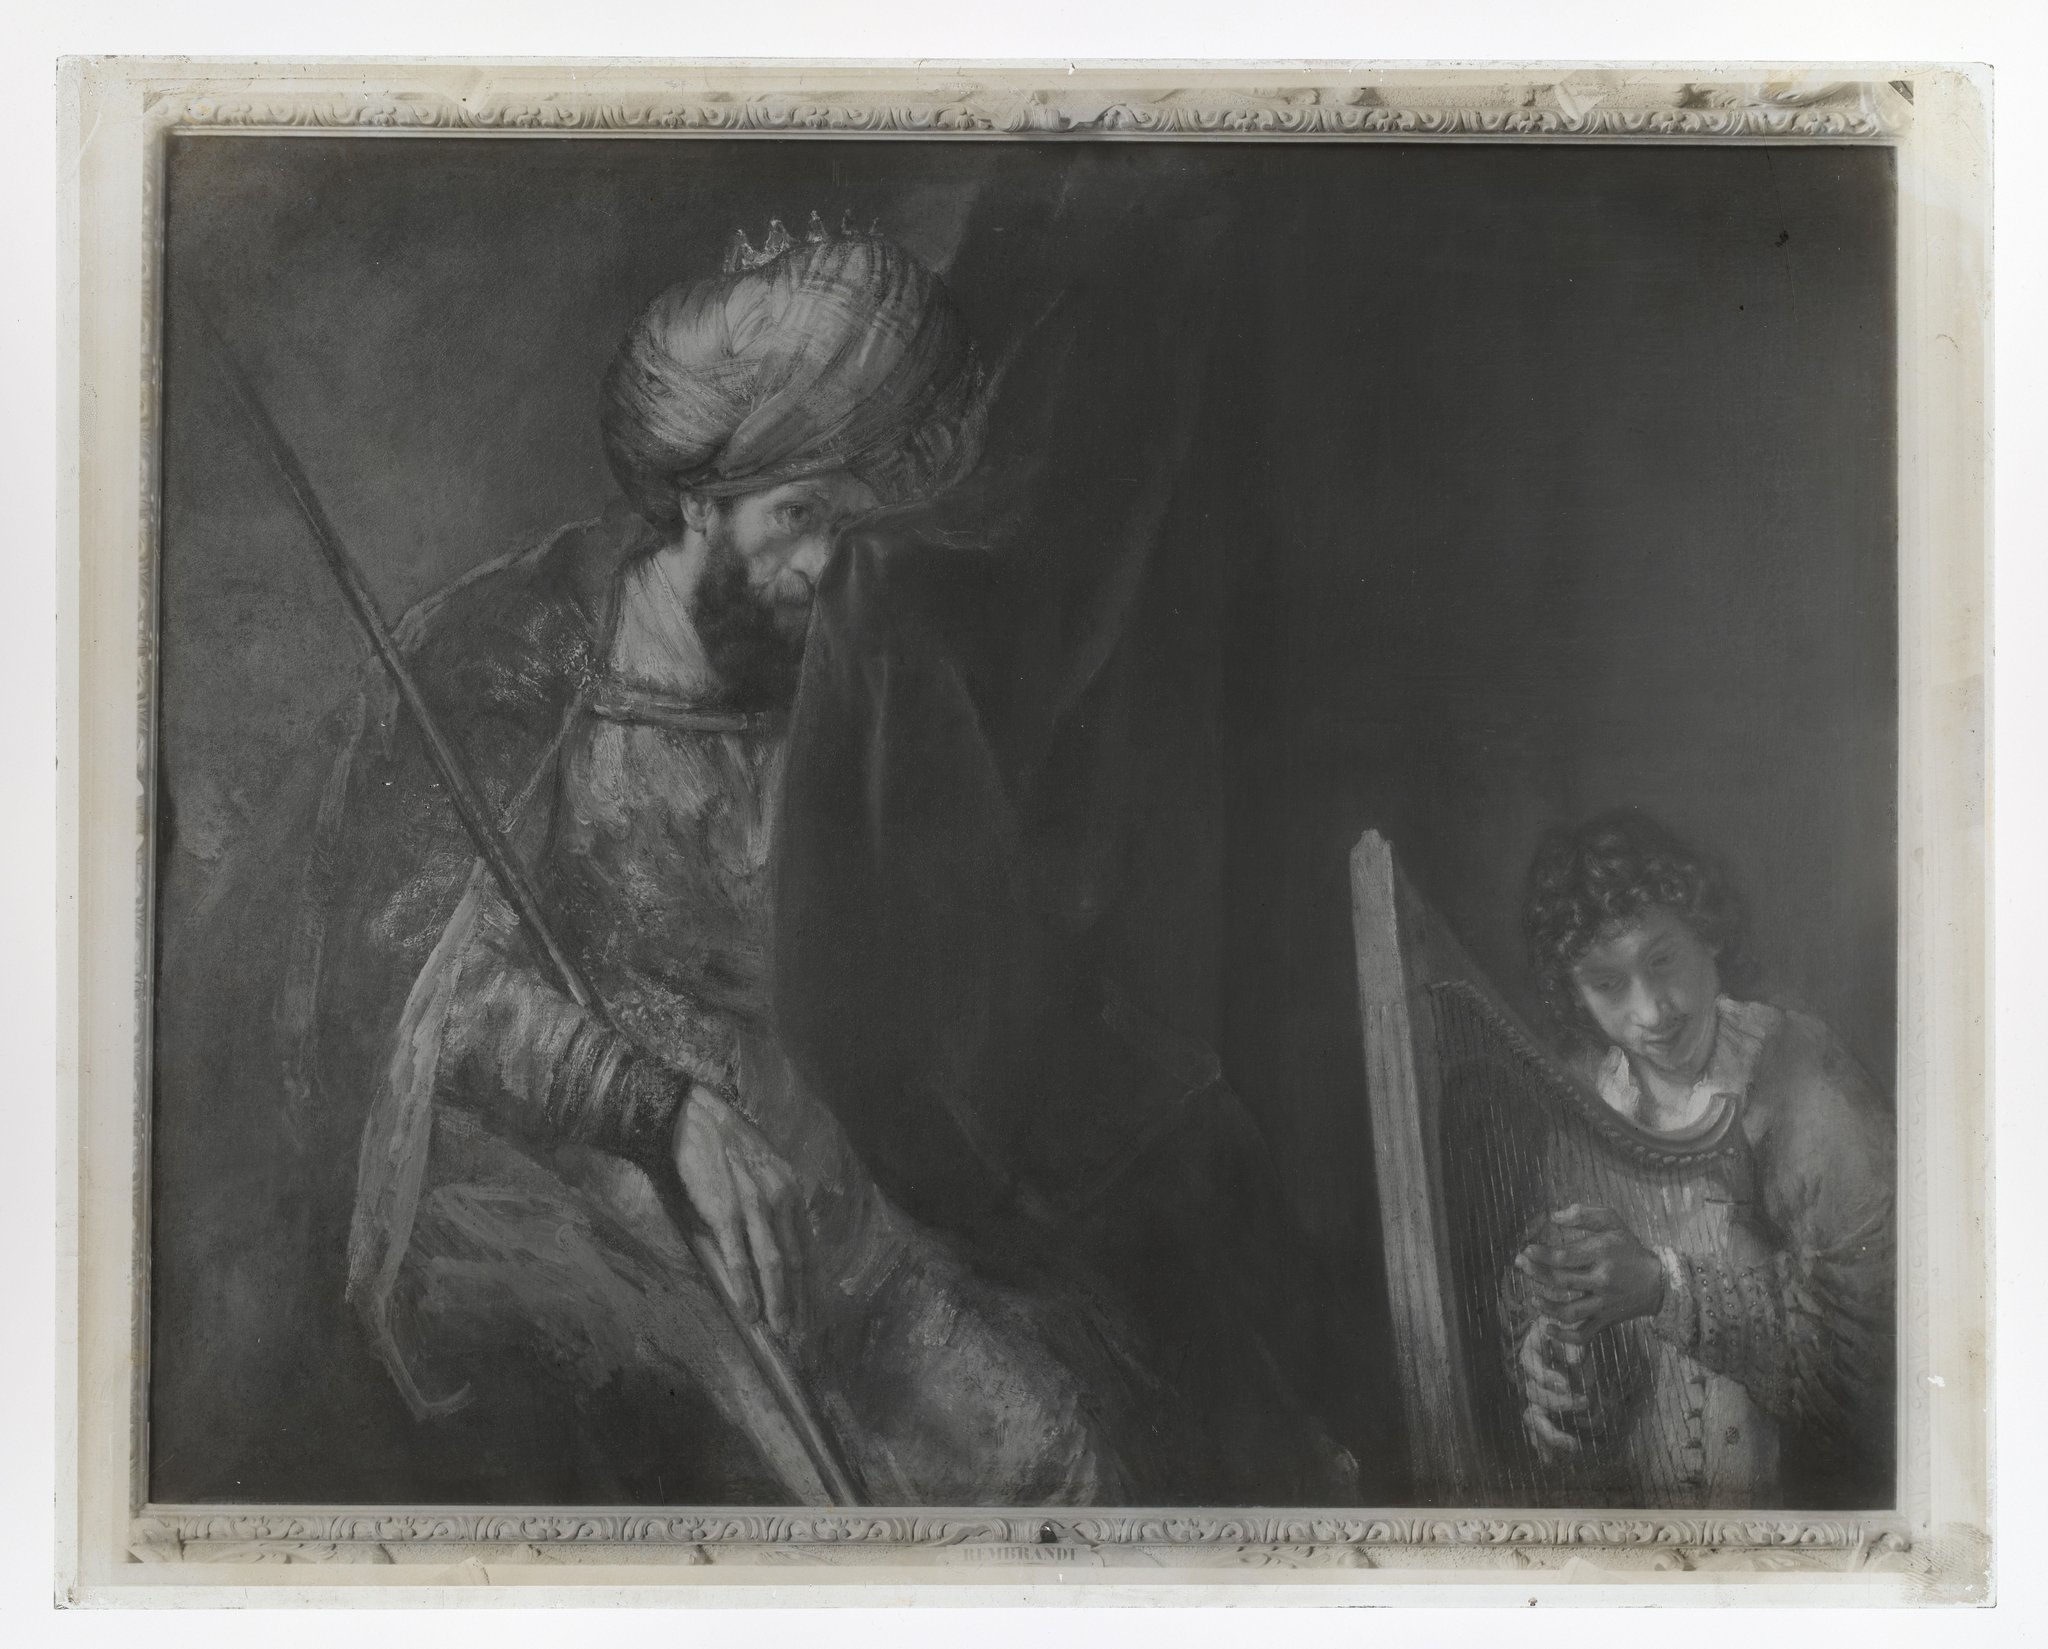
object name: reproduction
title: Fotoreproductie van het schilderij Saul en David door Rembrandt van Rijn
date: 1890-1930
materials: glass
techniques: gelatin silver transparency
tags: david playing his harp before saul, saul troubled by an evil spirit